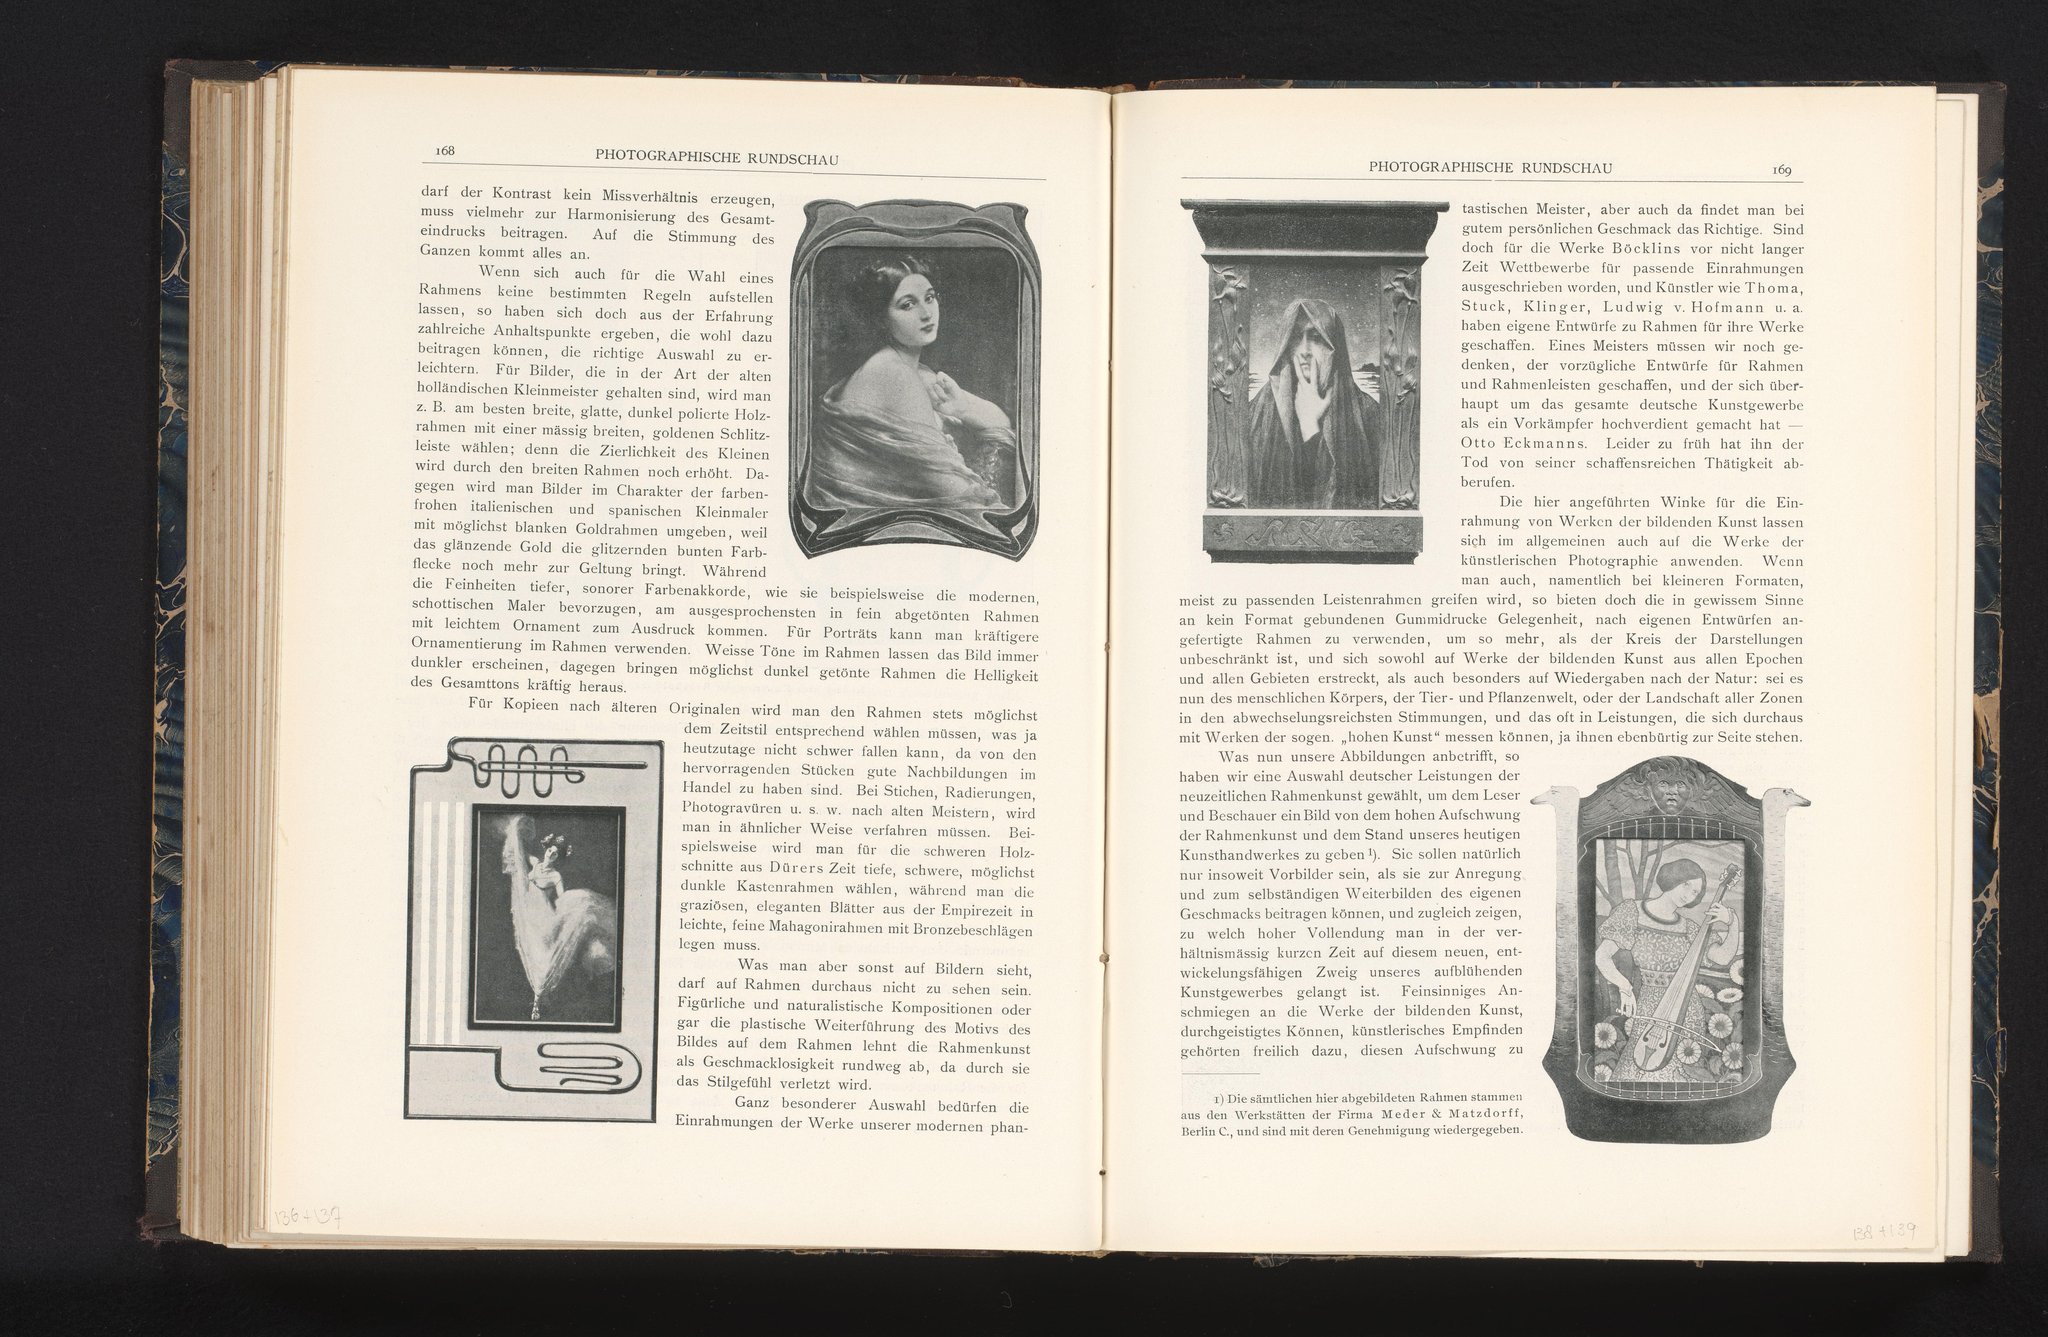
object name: photomechanical print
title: Gezicht op een lijst met een portret van een onbekende vrouw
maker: Anonymous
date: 1897-1902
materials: paper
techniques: autotype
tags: adult woman, frame of painting, etc.